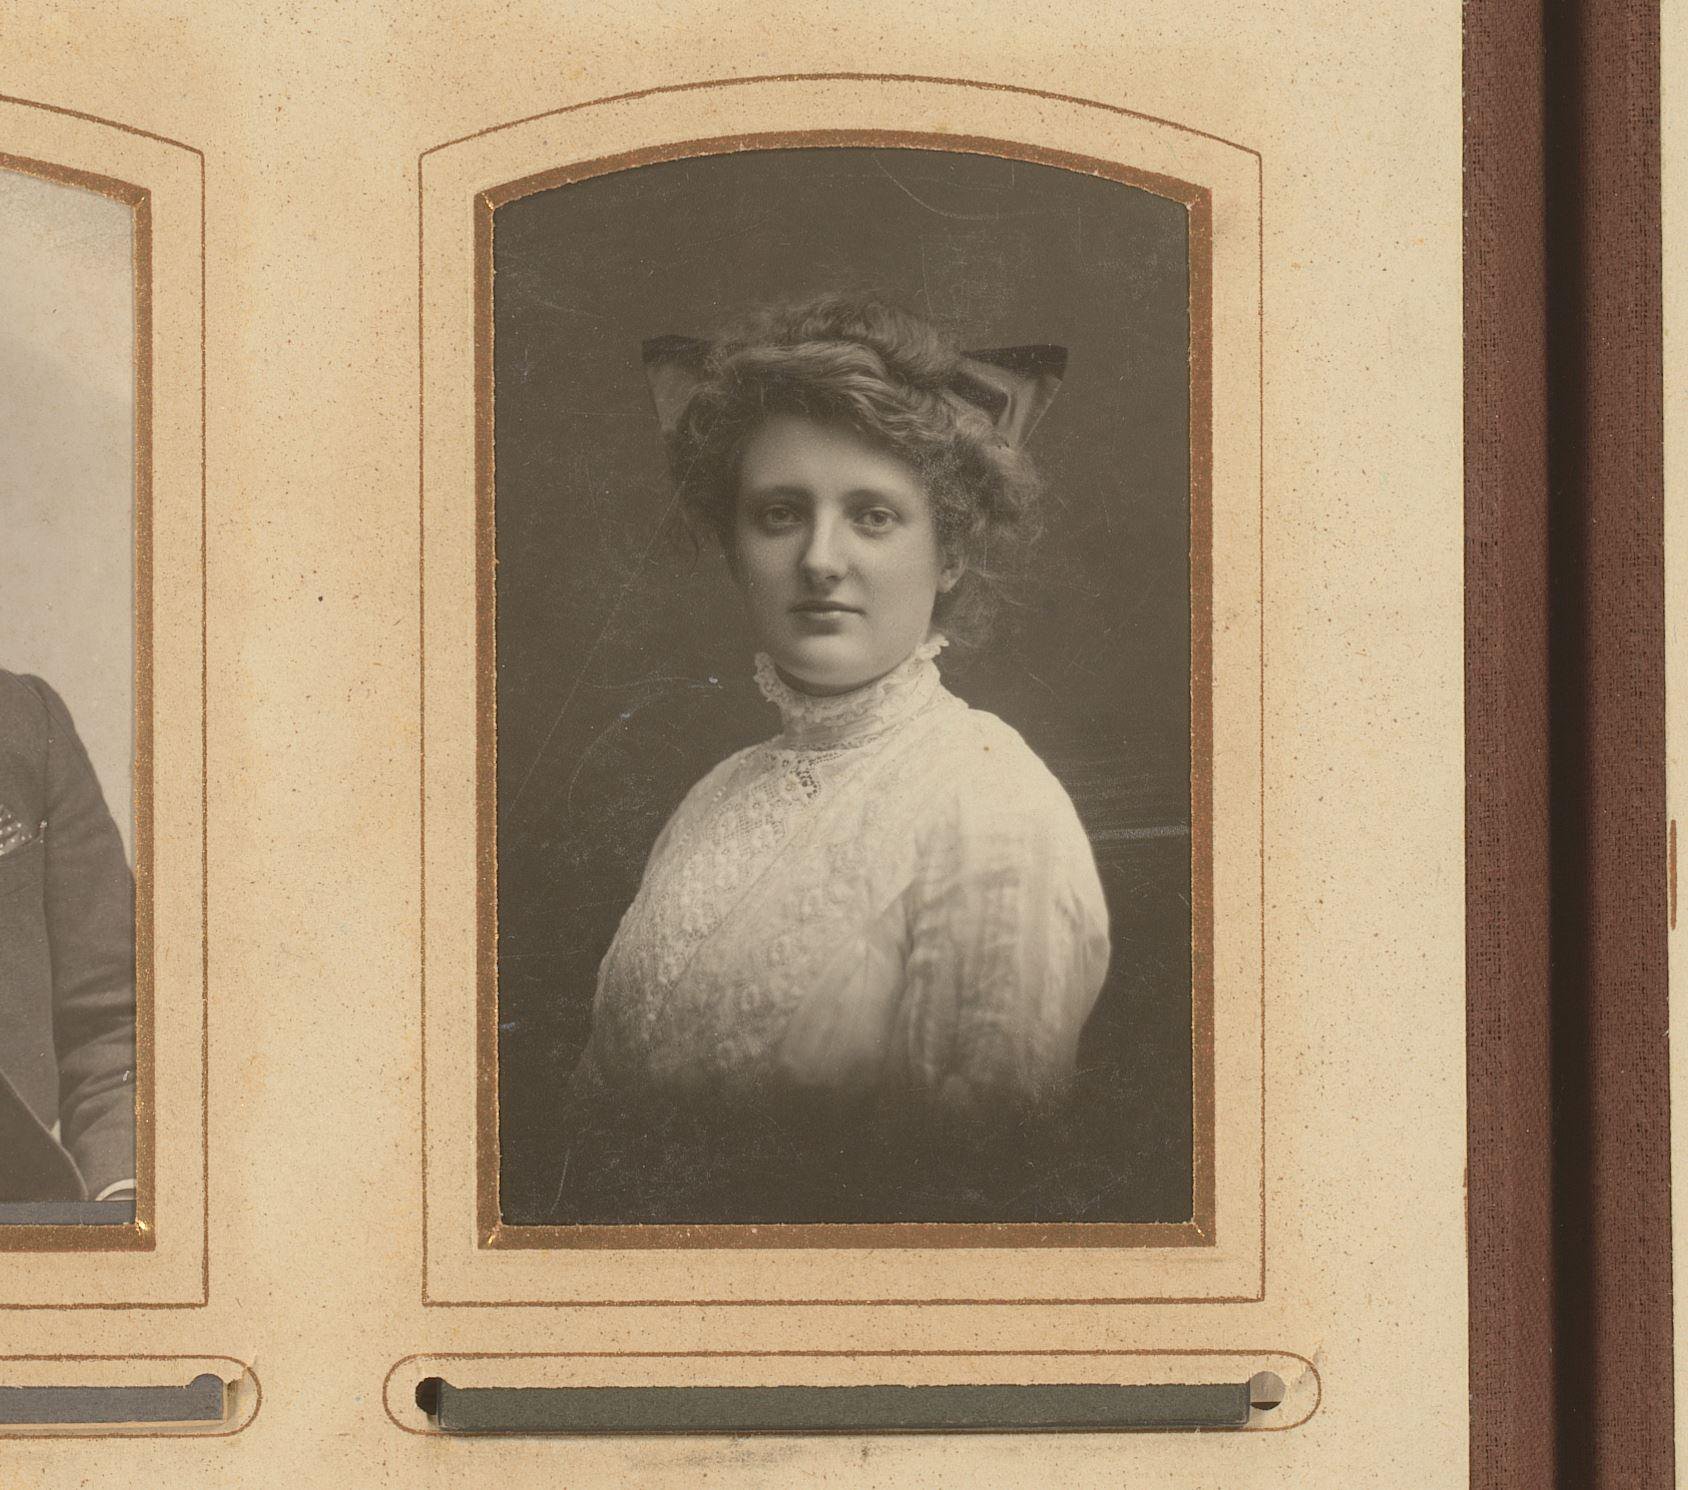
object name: album leaf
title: Portret van een jonge vrouw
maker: anton cornelis thomann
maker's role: fotograaf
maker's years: 1873-1946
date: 1894-1920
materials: cardboard, photographic support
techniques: collodion silver print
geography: amsterdam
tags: adolescent, young woman, maiden, historical persons - bb - woman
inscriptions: annotation: ‘Mies v. [...]/ (kweekschool)’, inscription: ‘Anton/ C. Thomann/ Fotograaf/ Utrecht’